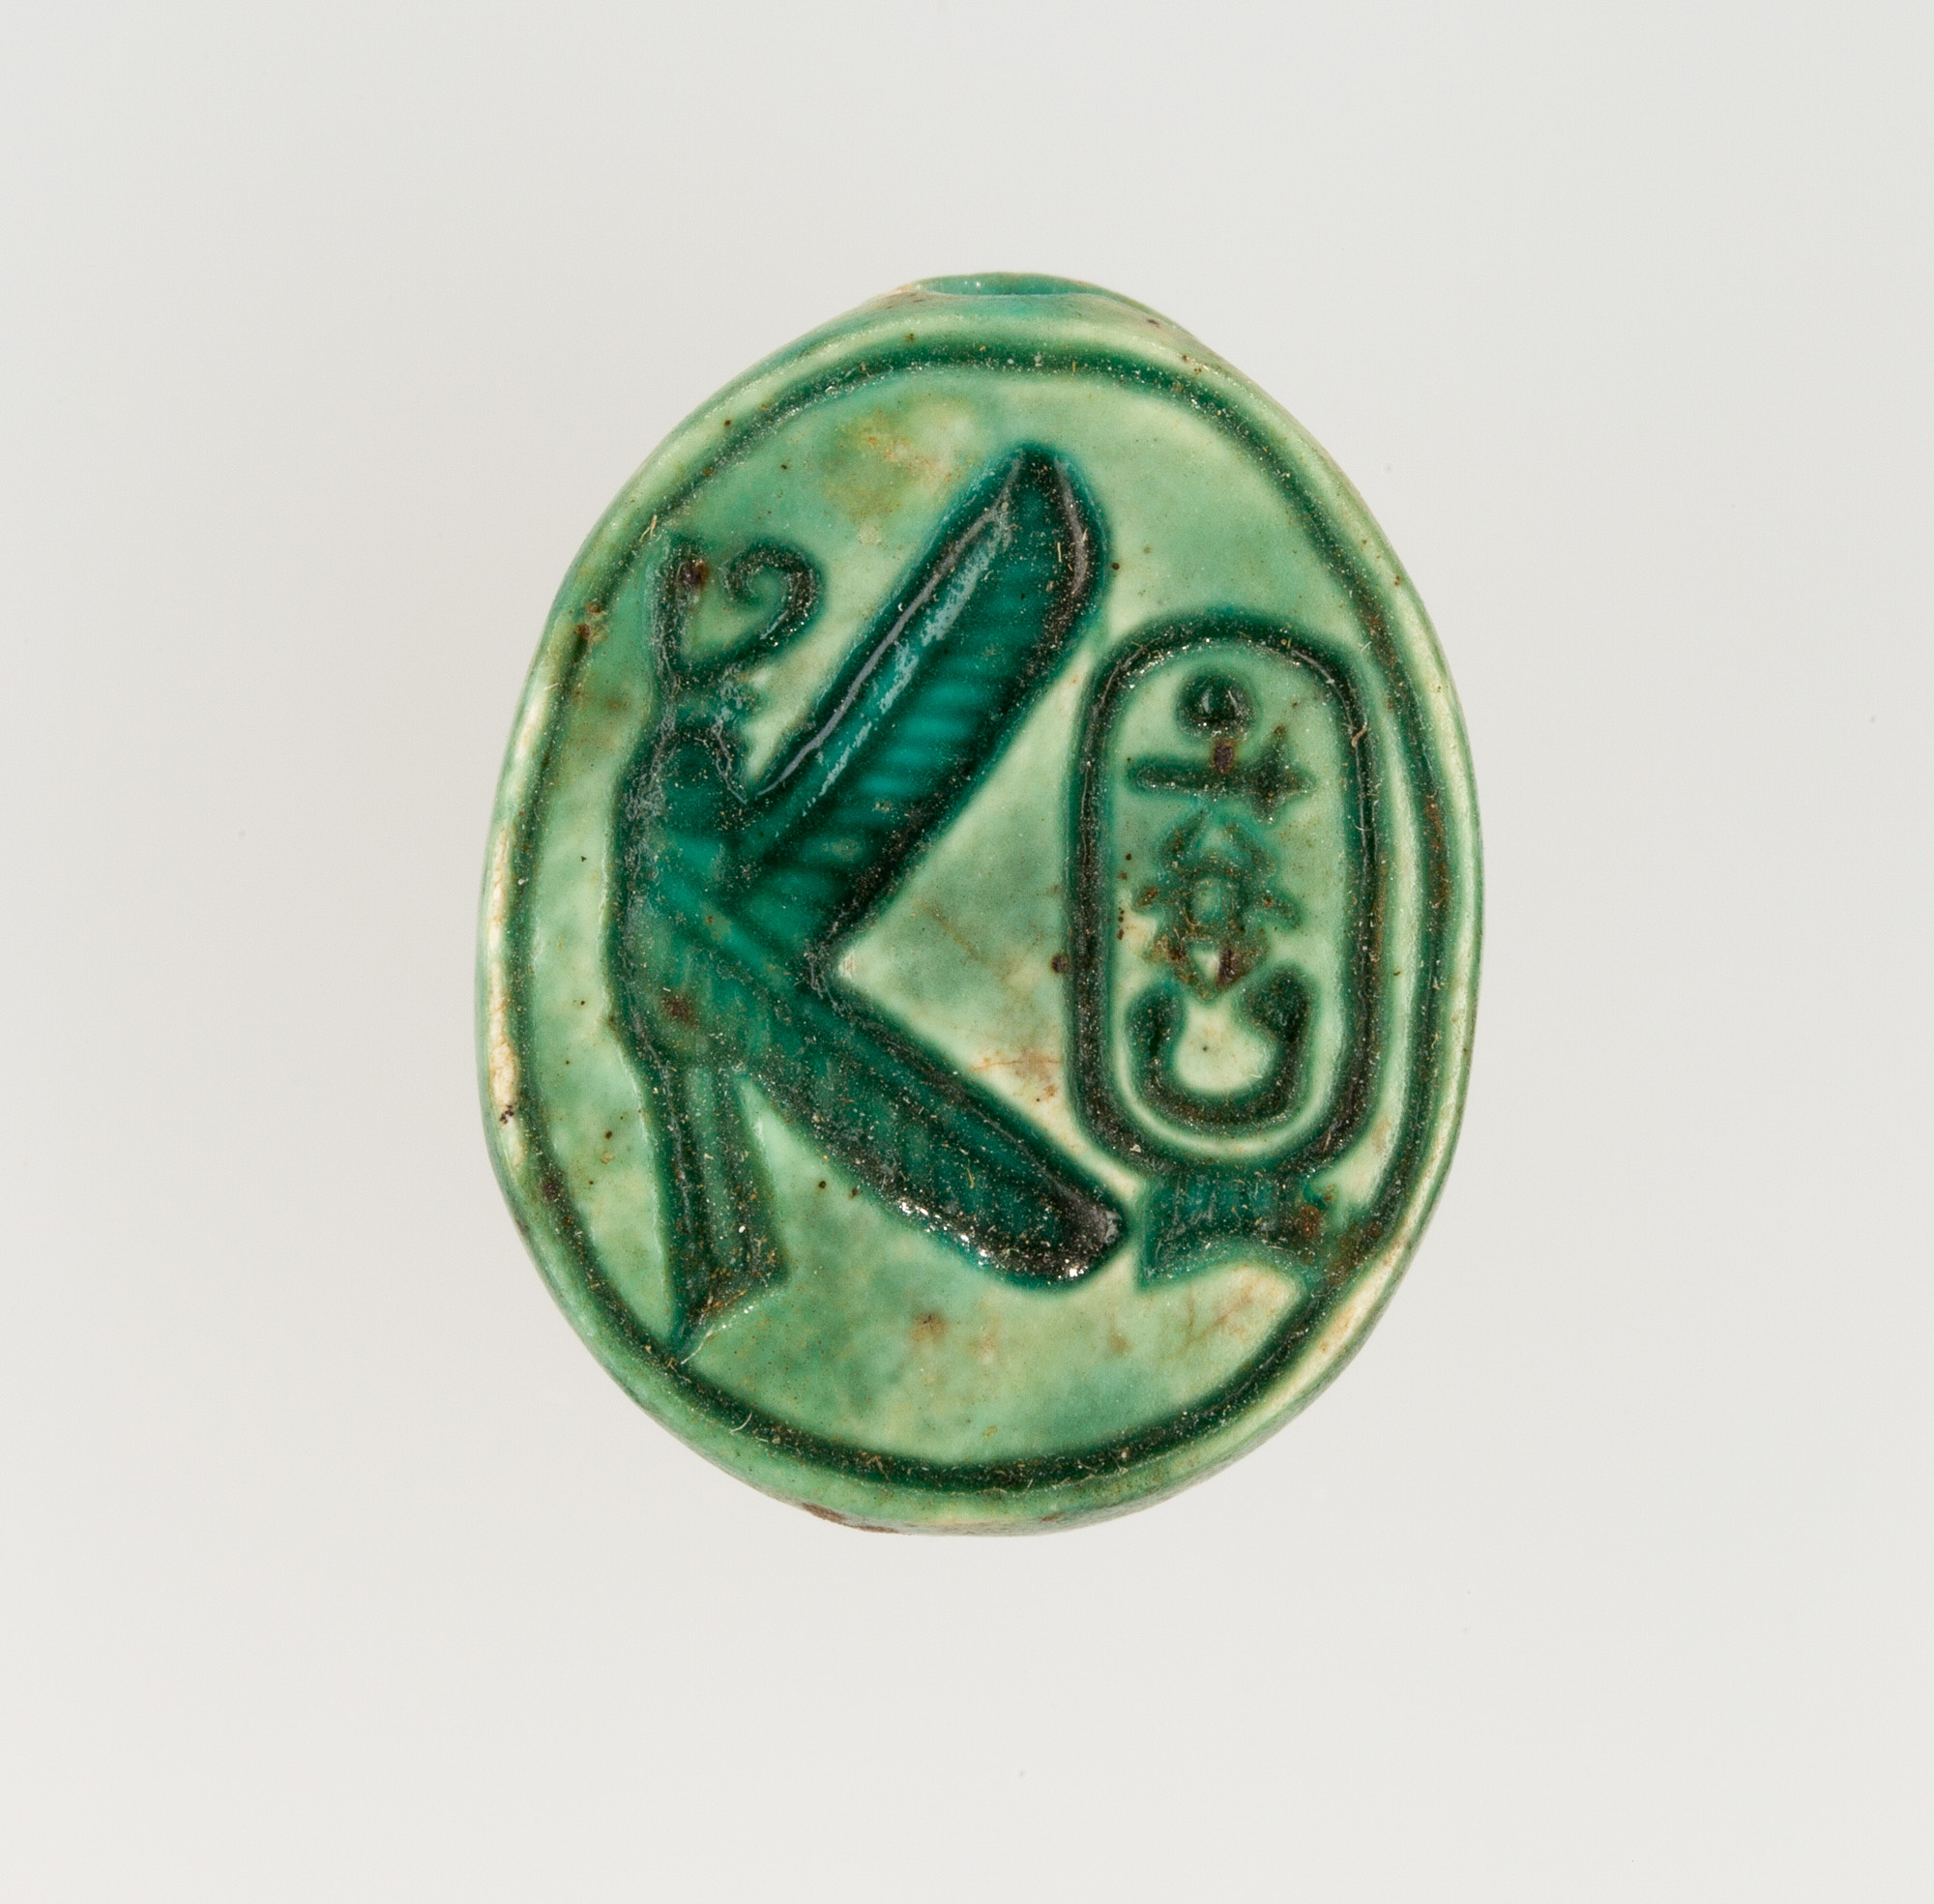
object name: scarab, thutmose i, aakheperkare, falcon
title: Scarab Inscribed with the Throne Name of Thutmose I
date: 1504-1492 BCE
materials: stone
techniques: glazing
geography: egypt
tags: cartouches,hieroglyphs,scarabs